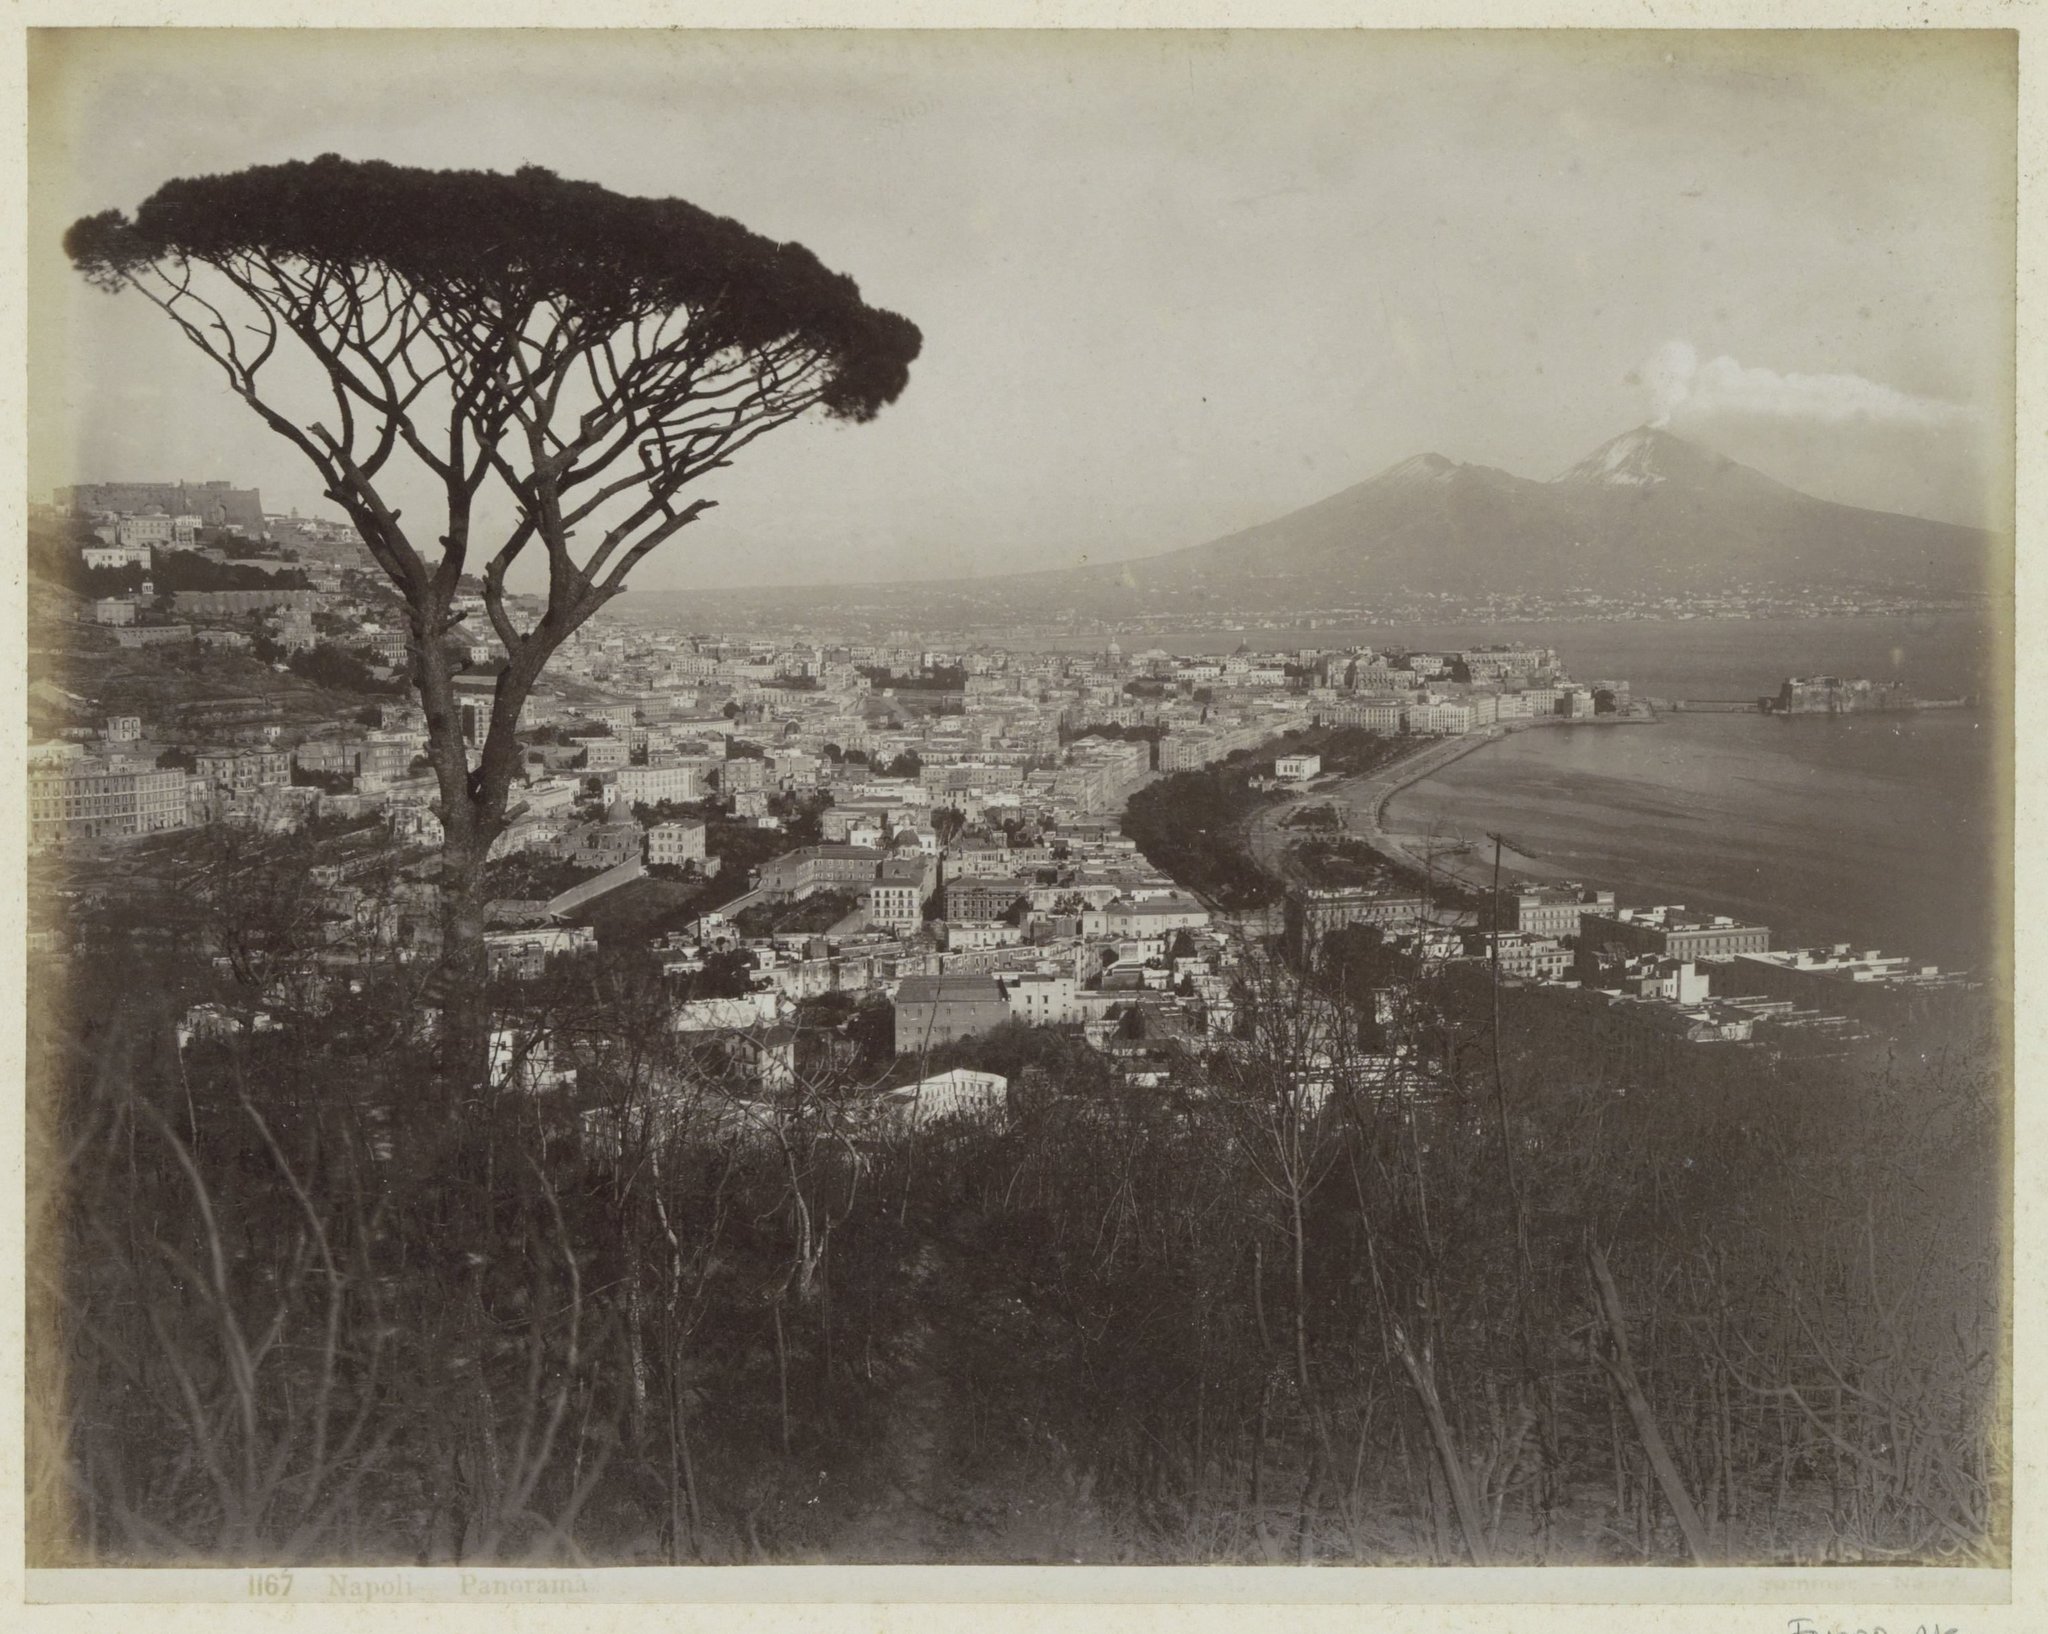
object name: photograph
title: Napoli Panorama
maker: giorgio sommer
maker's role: fotograaf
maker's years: 1834-1914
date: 1870-1900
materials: paper, photographic support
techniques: albumen print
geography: naples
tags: volcano, prospect of city, town panorama, silhouette of city, naples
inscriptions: negative number: ‘1167’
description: Onderdeel van Reisalbum met foto's van bezienswaardigheden in Italië en Frankrijk.